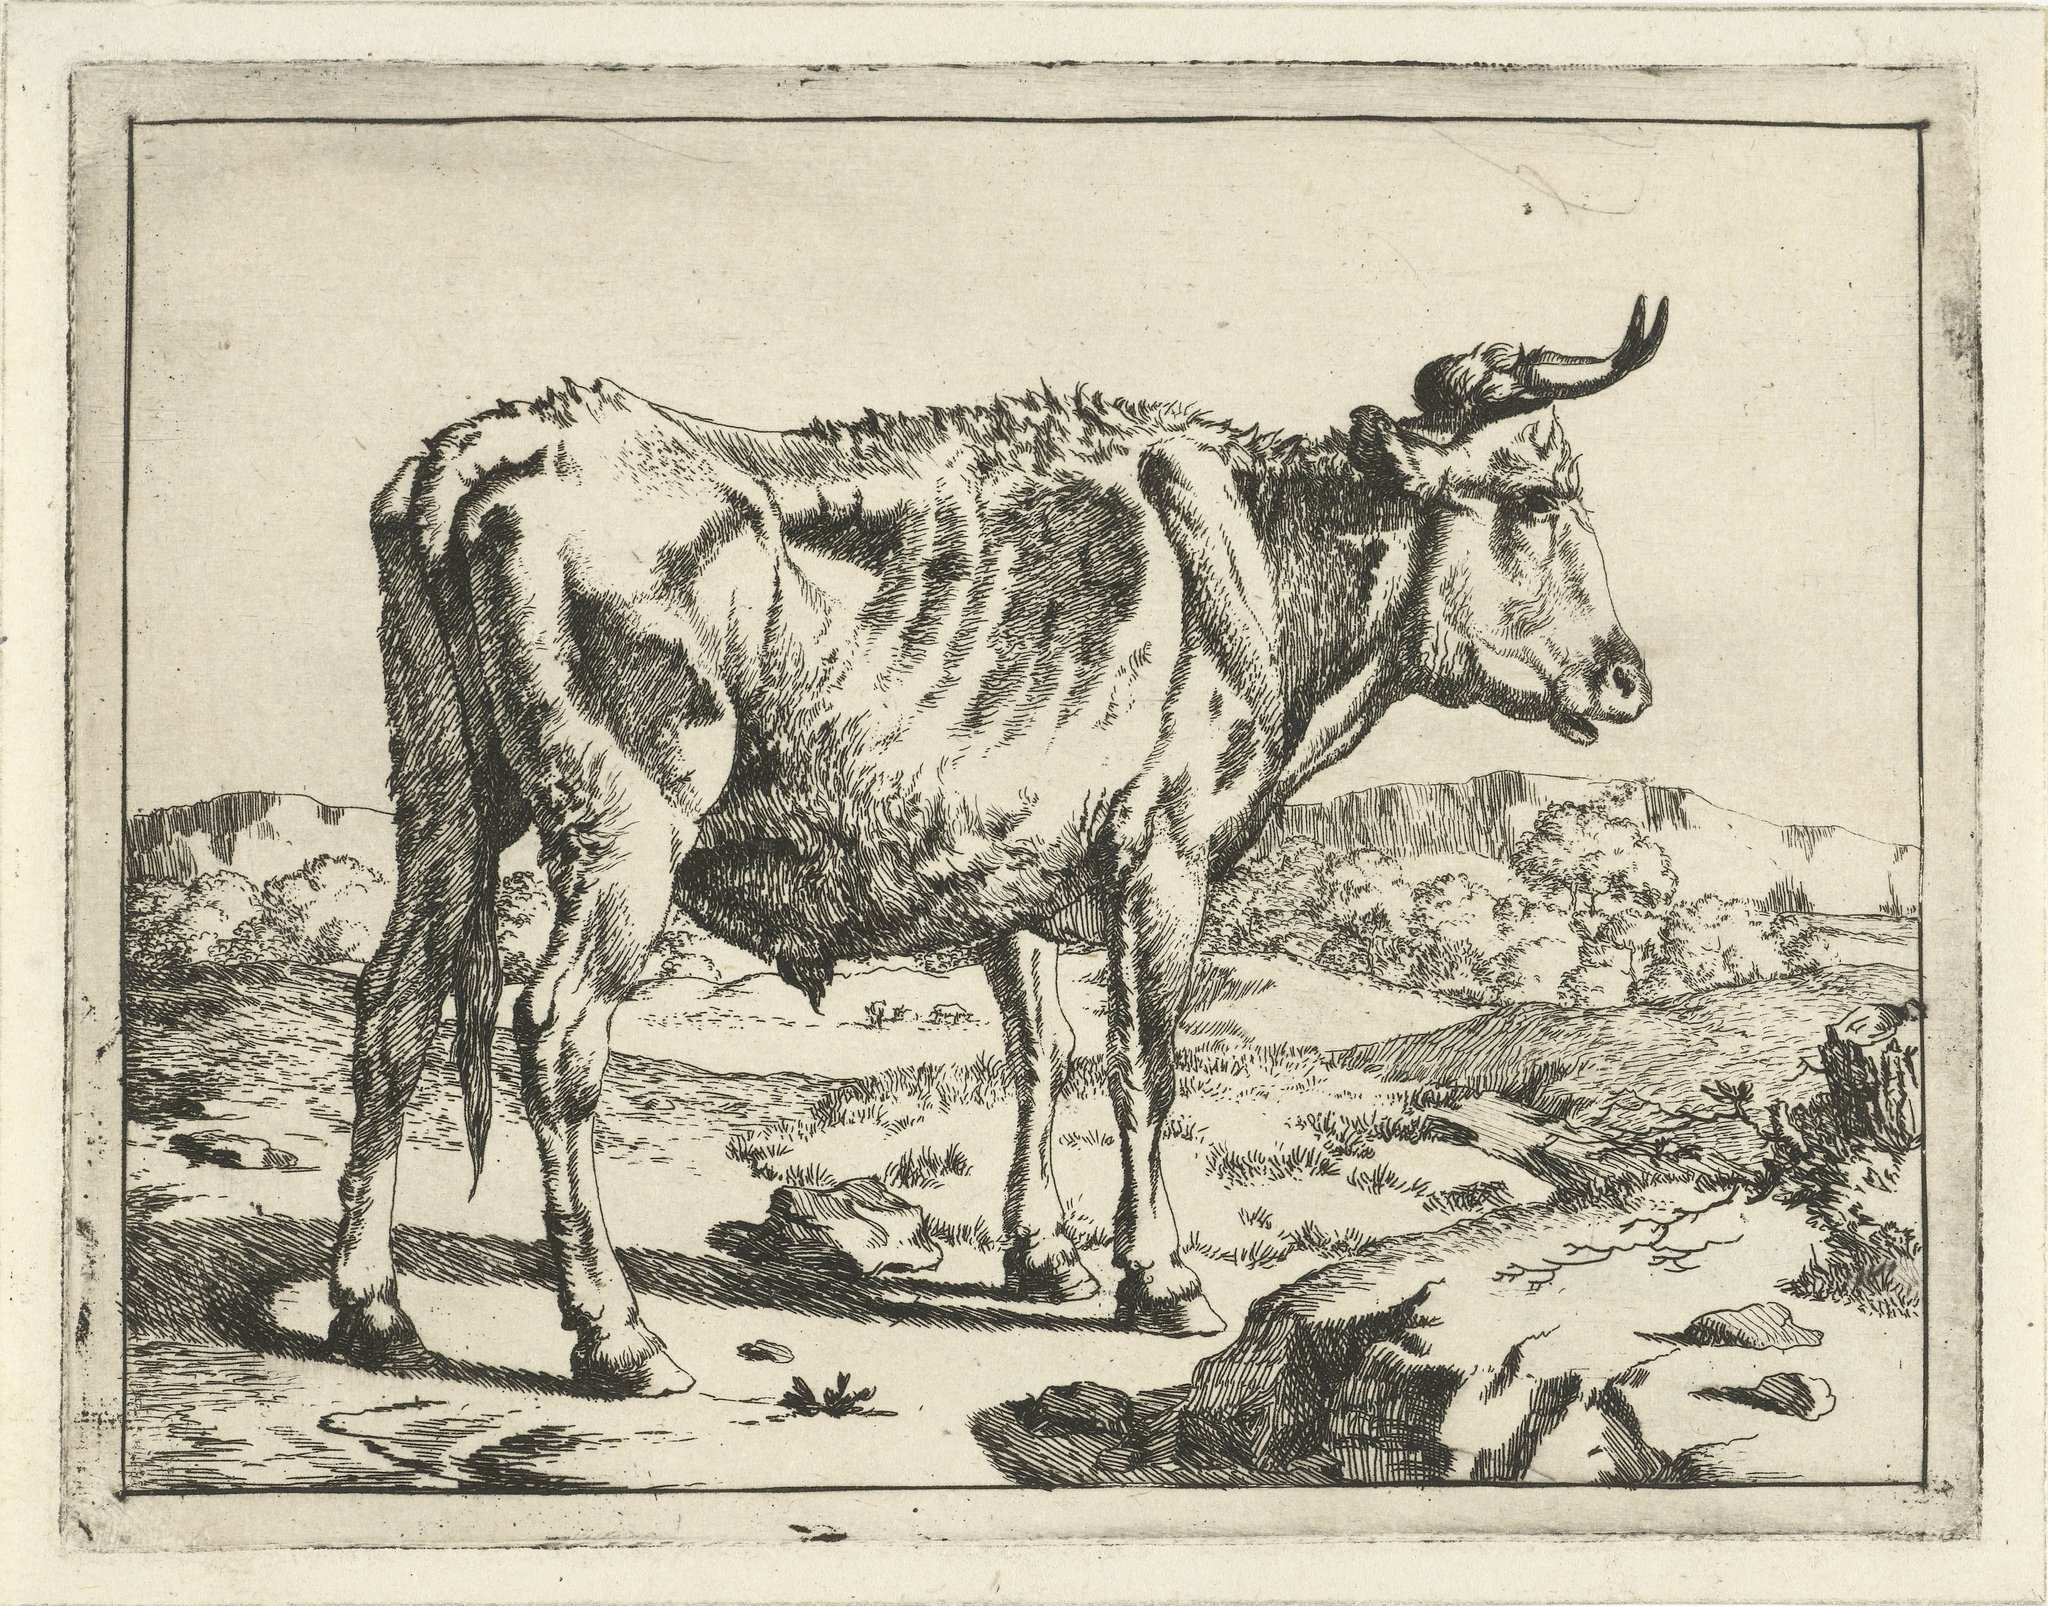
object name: print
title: Runderen en varkens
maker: marcus de bye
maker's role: print maker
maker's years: 1639-1688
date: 1649-1677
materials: paper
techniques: etching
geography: the hague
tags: cow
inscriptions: collector's mark: Lugt 2228